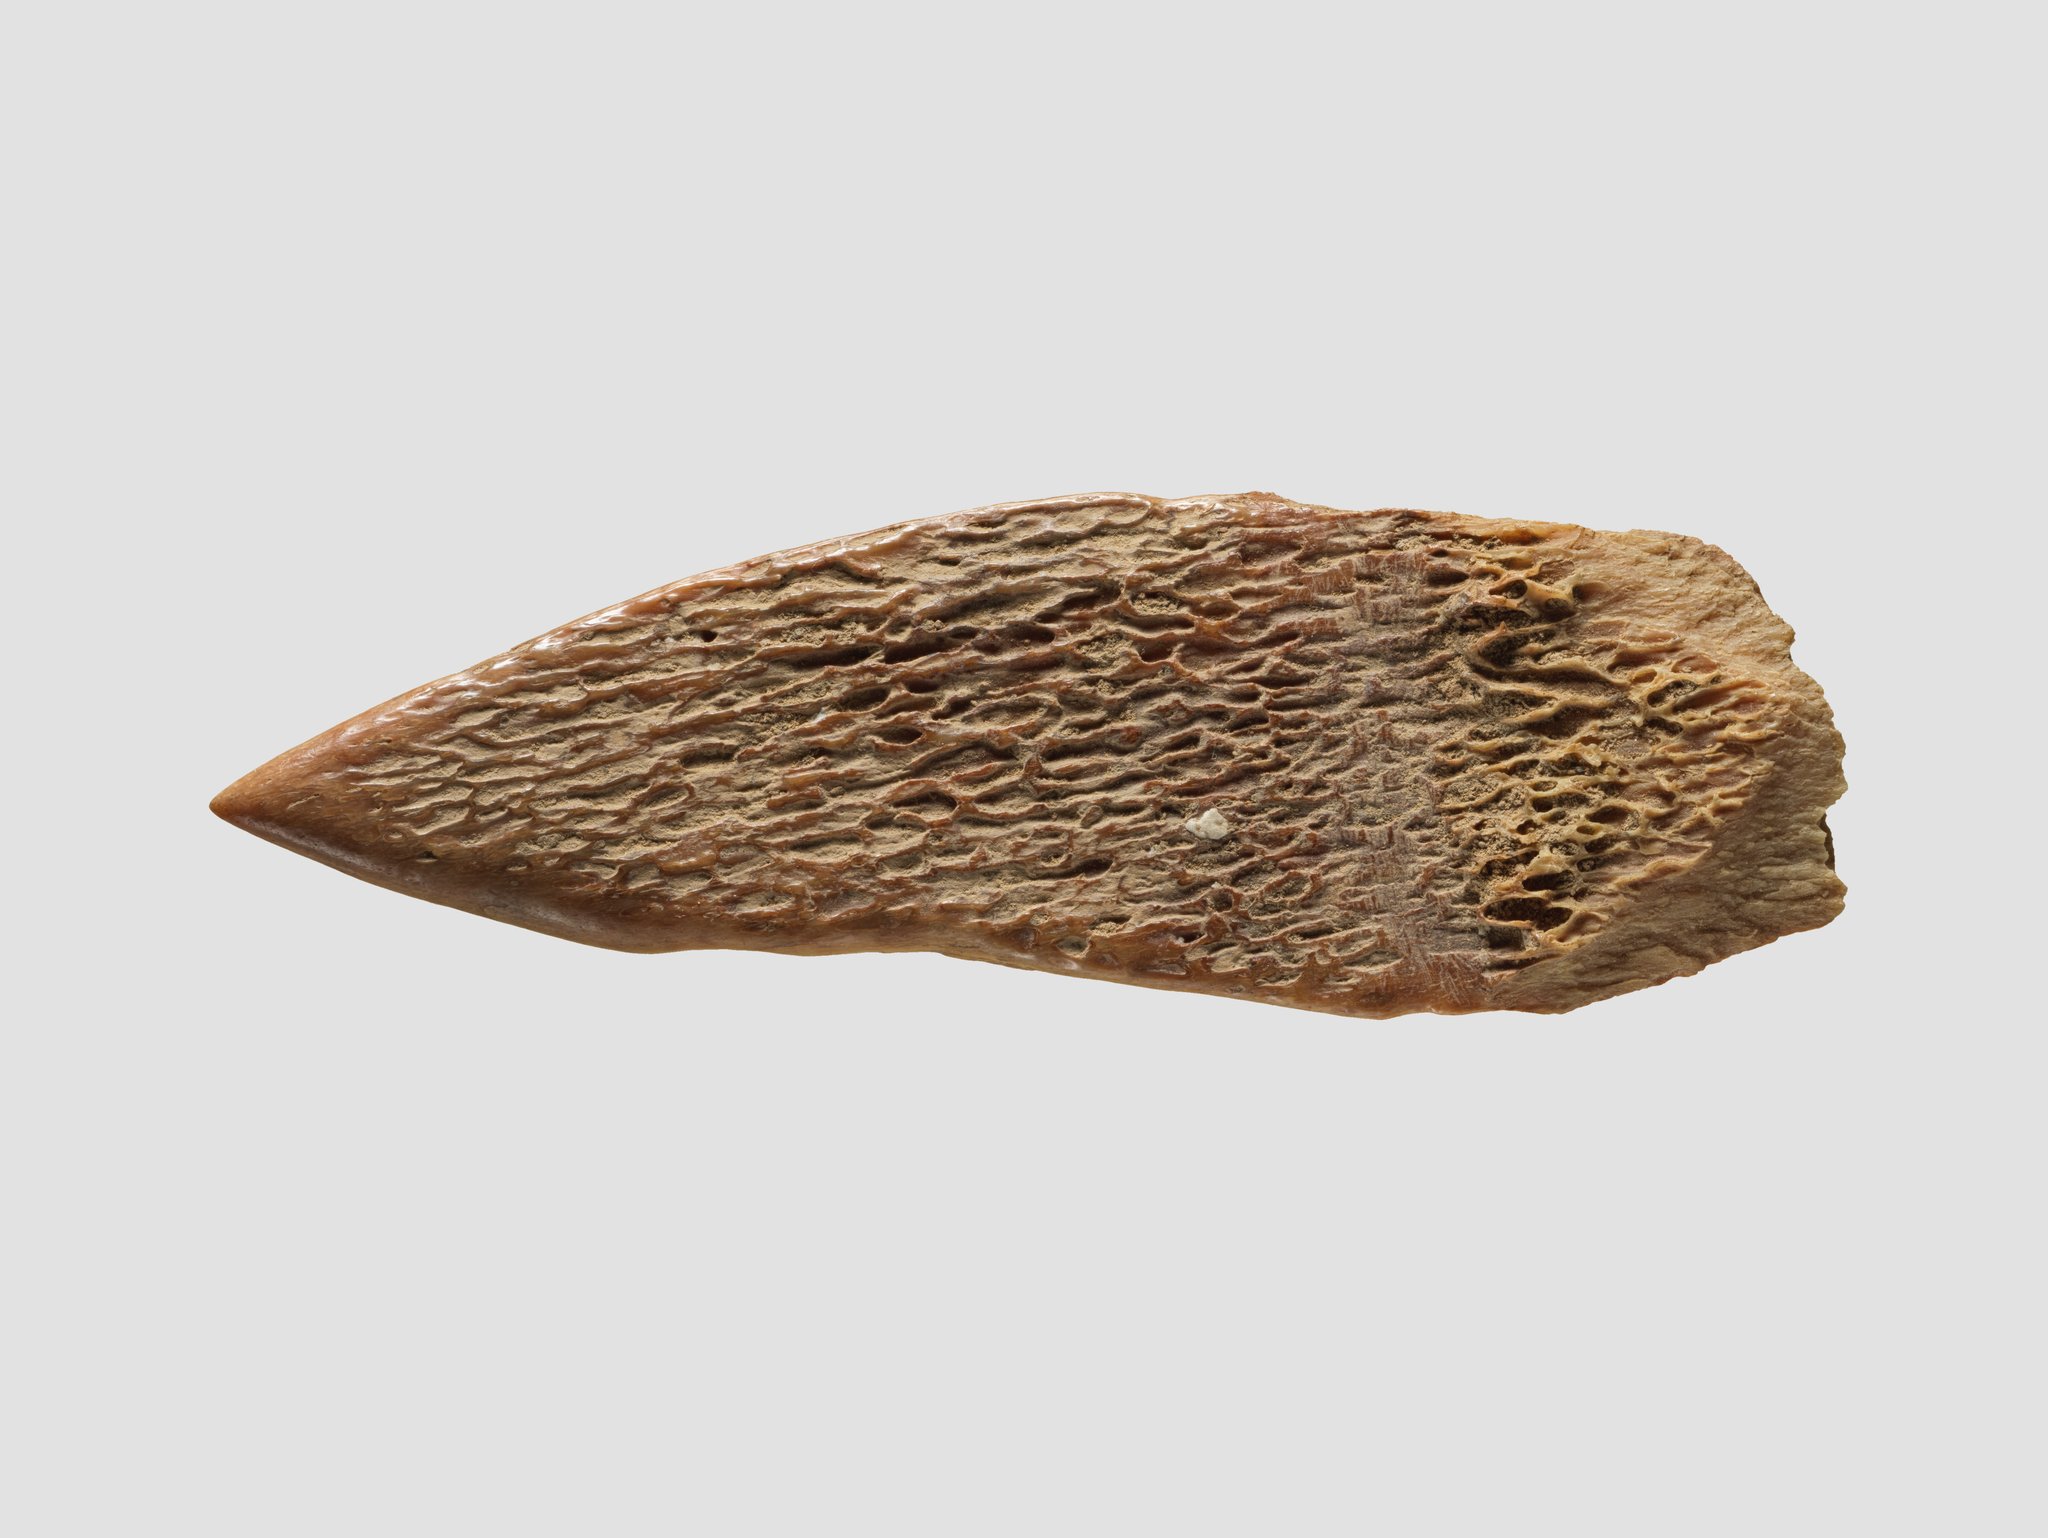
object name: tool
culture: iranian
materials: bone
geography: iran